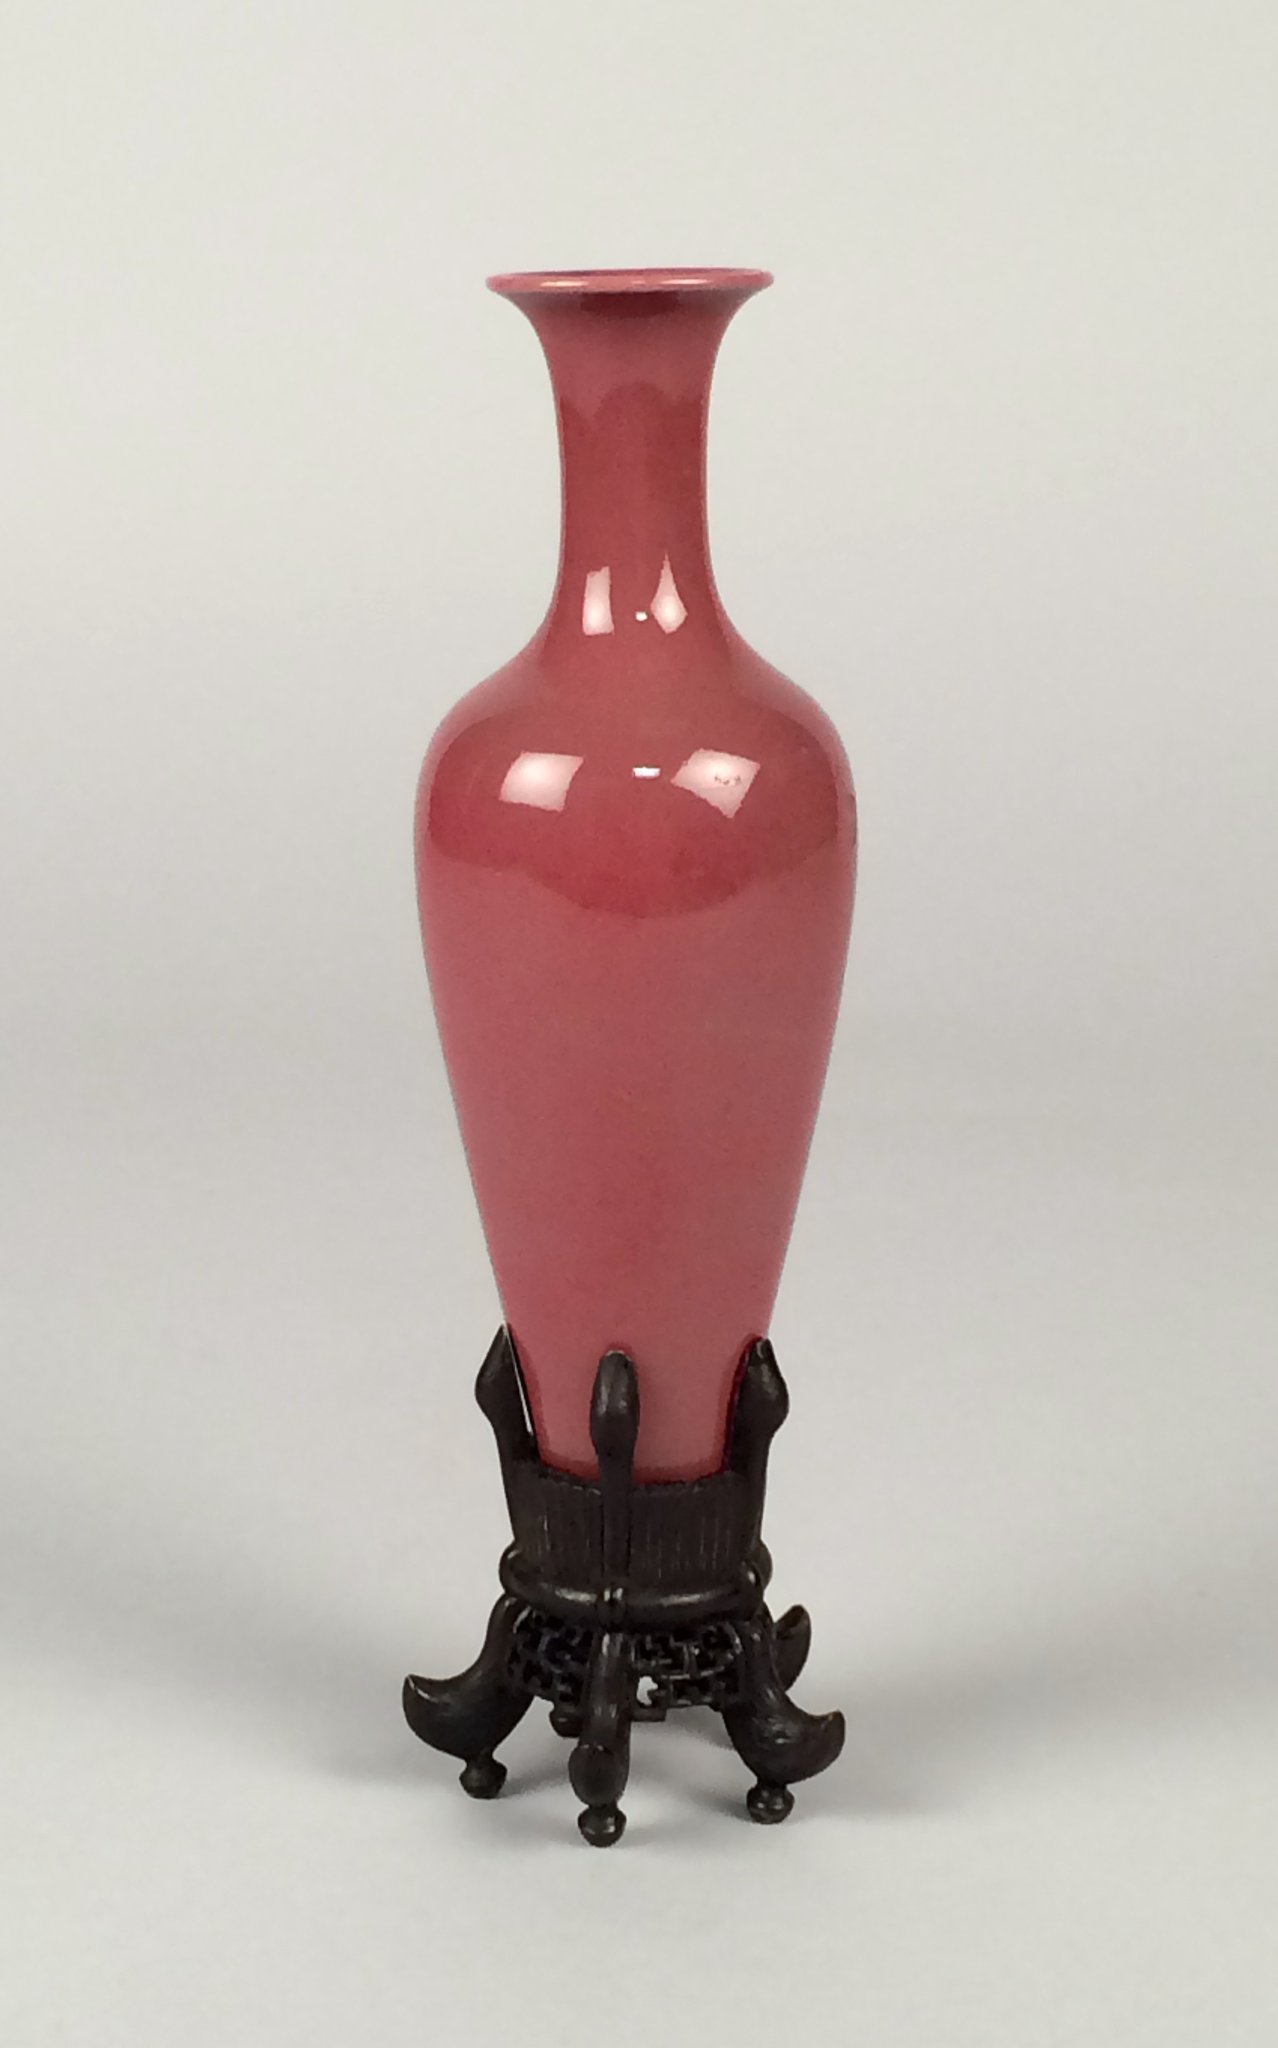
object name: vase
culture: chinese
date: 1662-1722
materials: glaze, porcelain, velvet, wood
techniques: carving